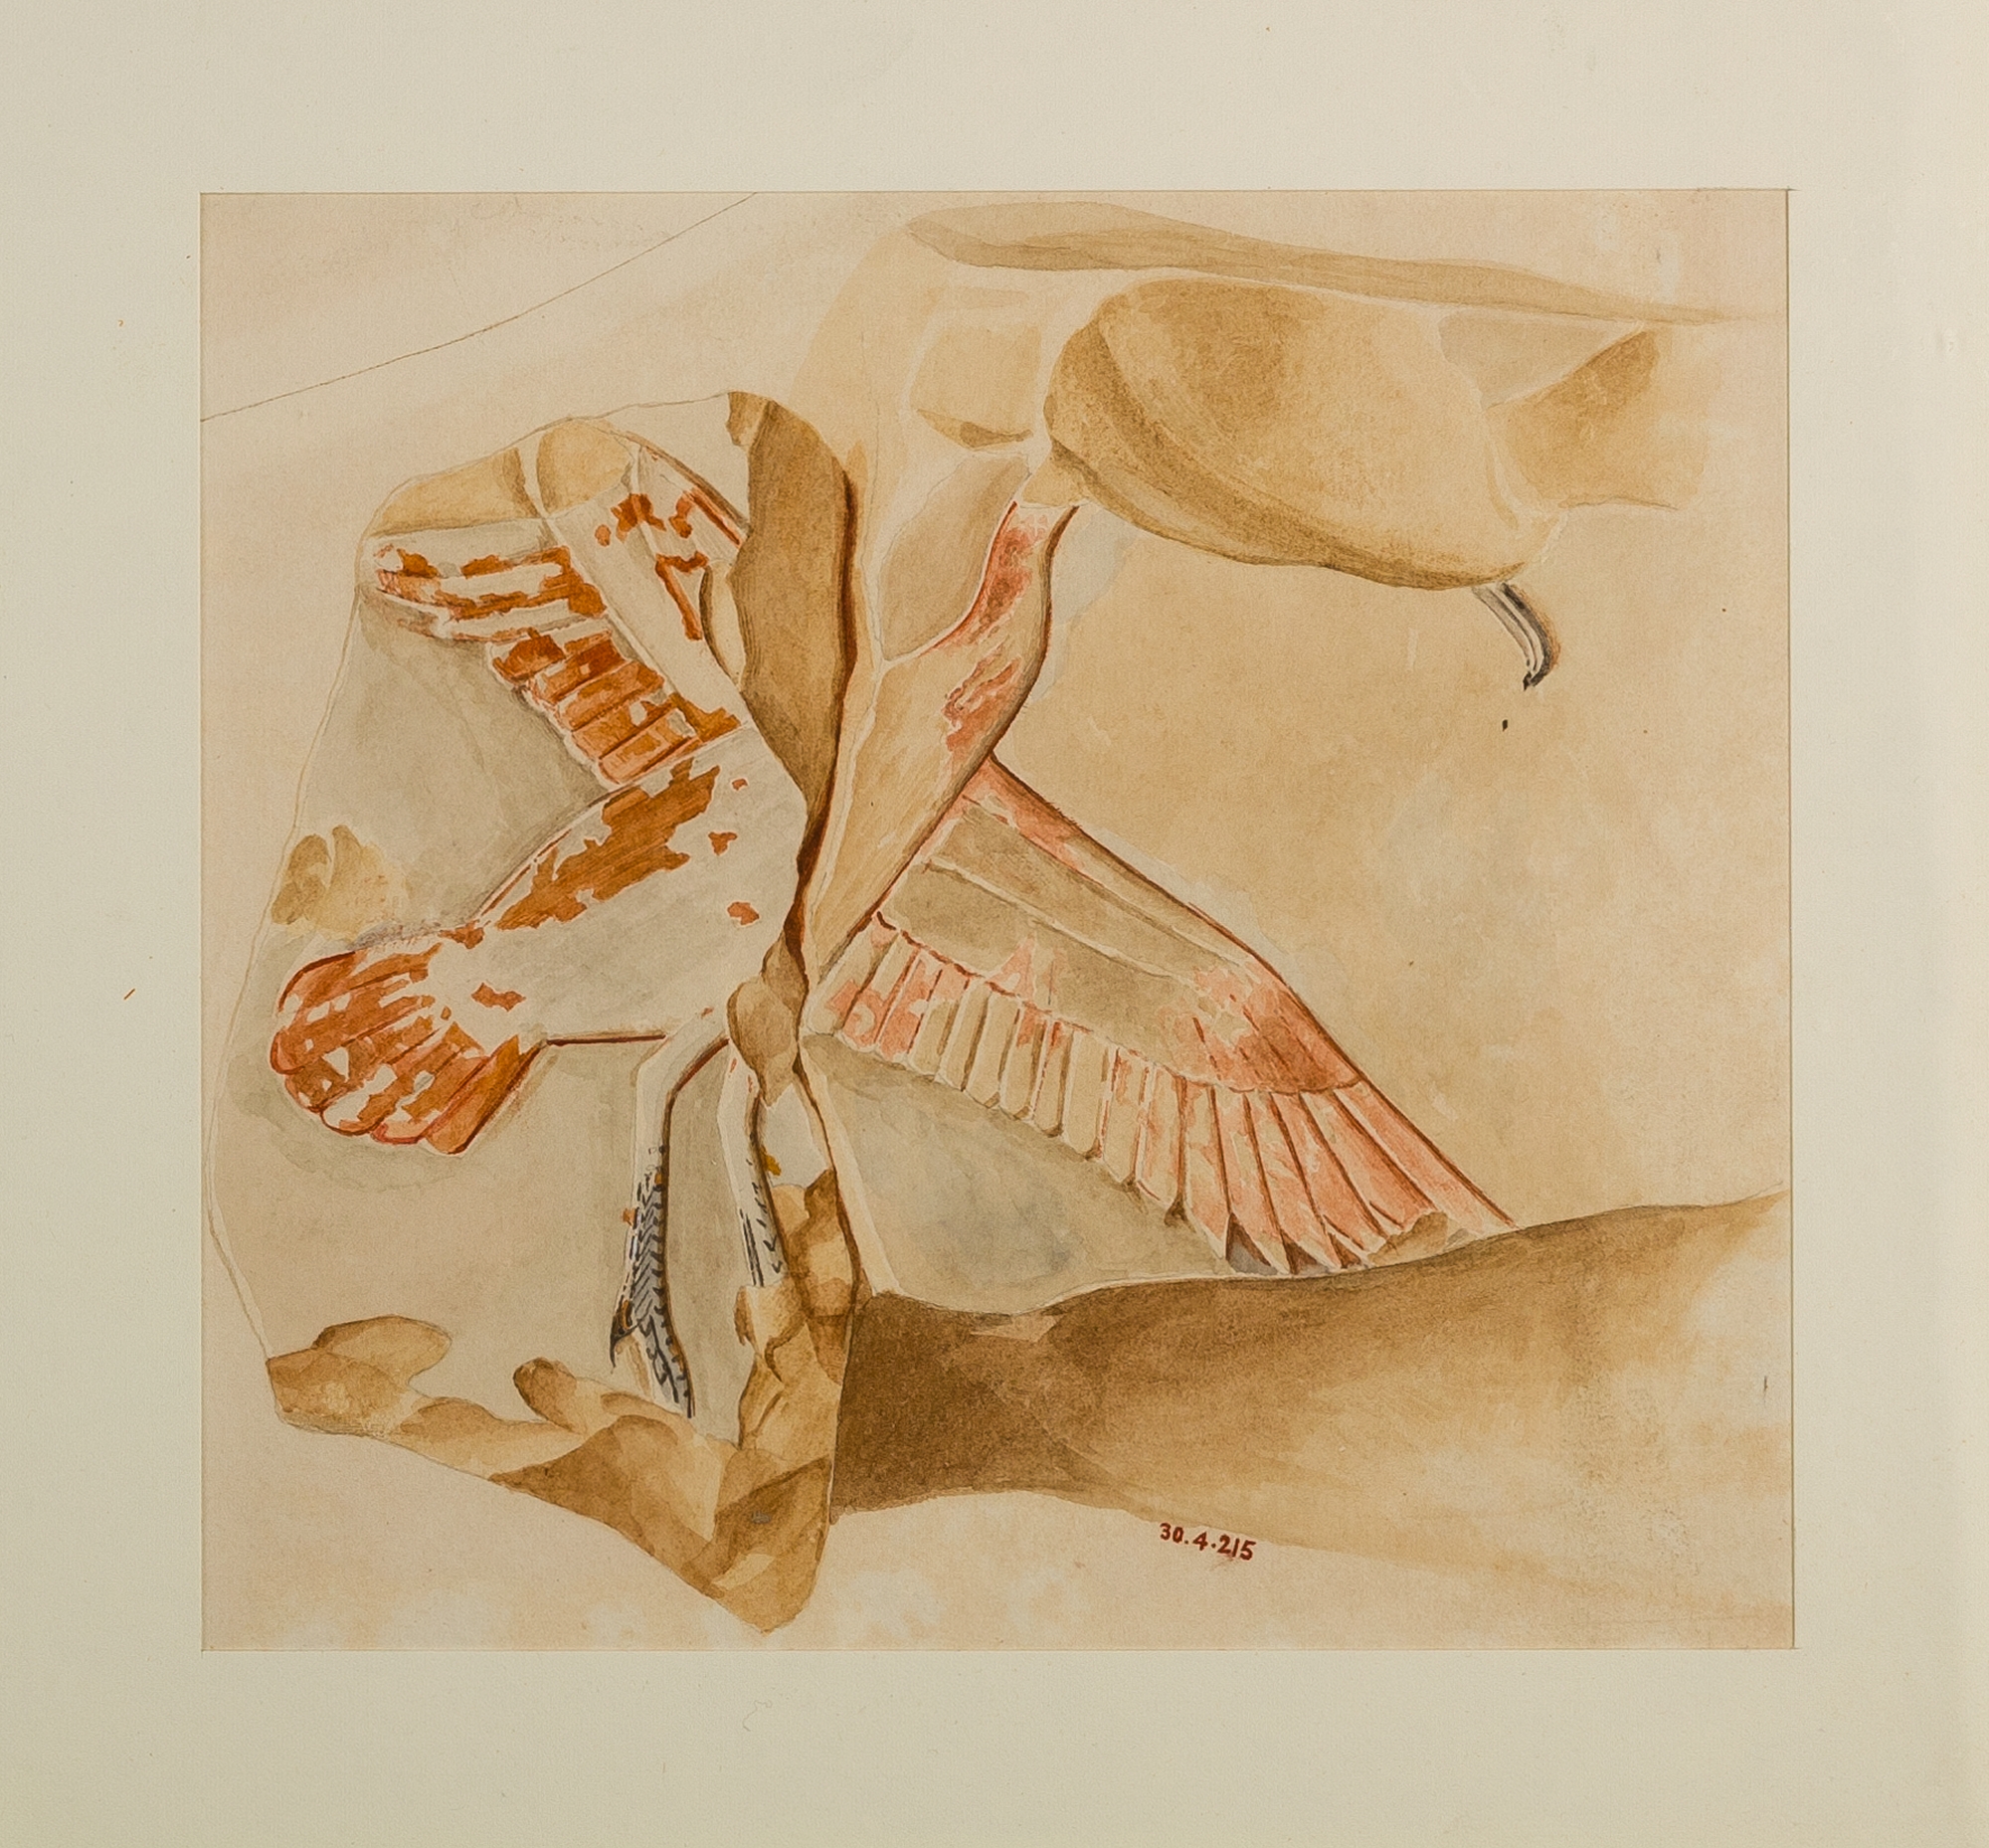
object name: facsimile, puyemre tt 39, water fowl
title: Water Fowl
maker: hugh r. hopgood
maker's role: artist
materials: paper, paint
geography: egypt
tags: birds